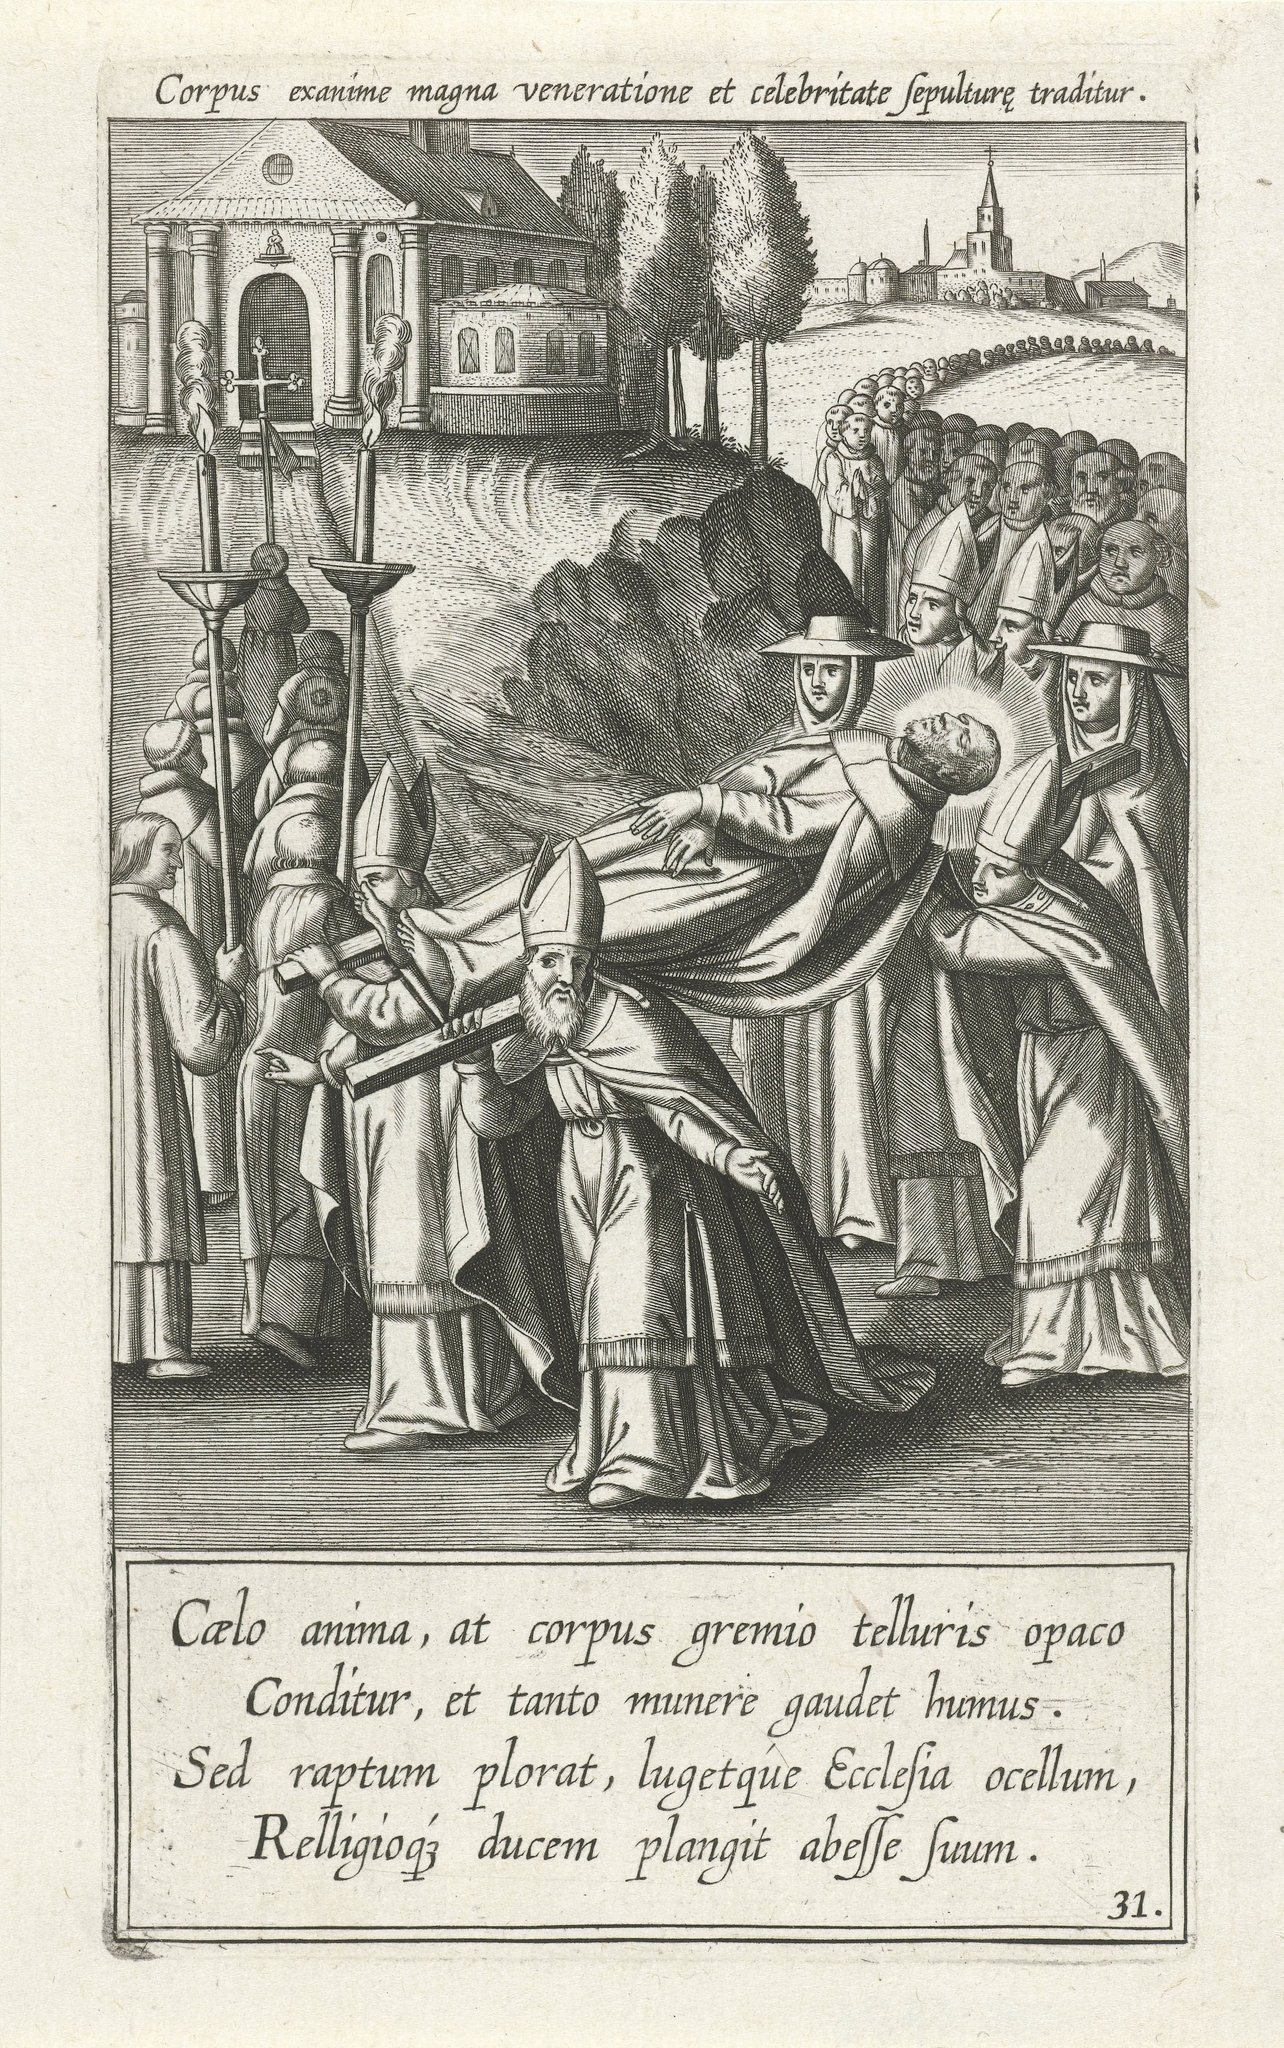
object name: book illustration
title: Leven en mirakels van de heilige Dominicus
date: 1611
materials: paper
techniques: engraving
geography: antwerp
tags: dominic(us) guzman of calerueja, founder of the order of preachers (or dominican (black) friars; possible attributes: book, dog with flaming torch, lily, loaf of bread, rosary, star - post-mortem occurrences ~ male saint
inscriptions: collector's mark: Lugt 2228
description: Het lijk van de heilige Dominicus wordt door vier bisschoppen de kerk binnengedragen. Een lange begrafenisstoet volgt. De prent heeft een Latijns opschrift en onderschrift en maakt deel uit van een prentserie voor een boek over het leven van de heilige Dominicus.